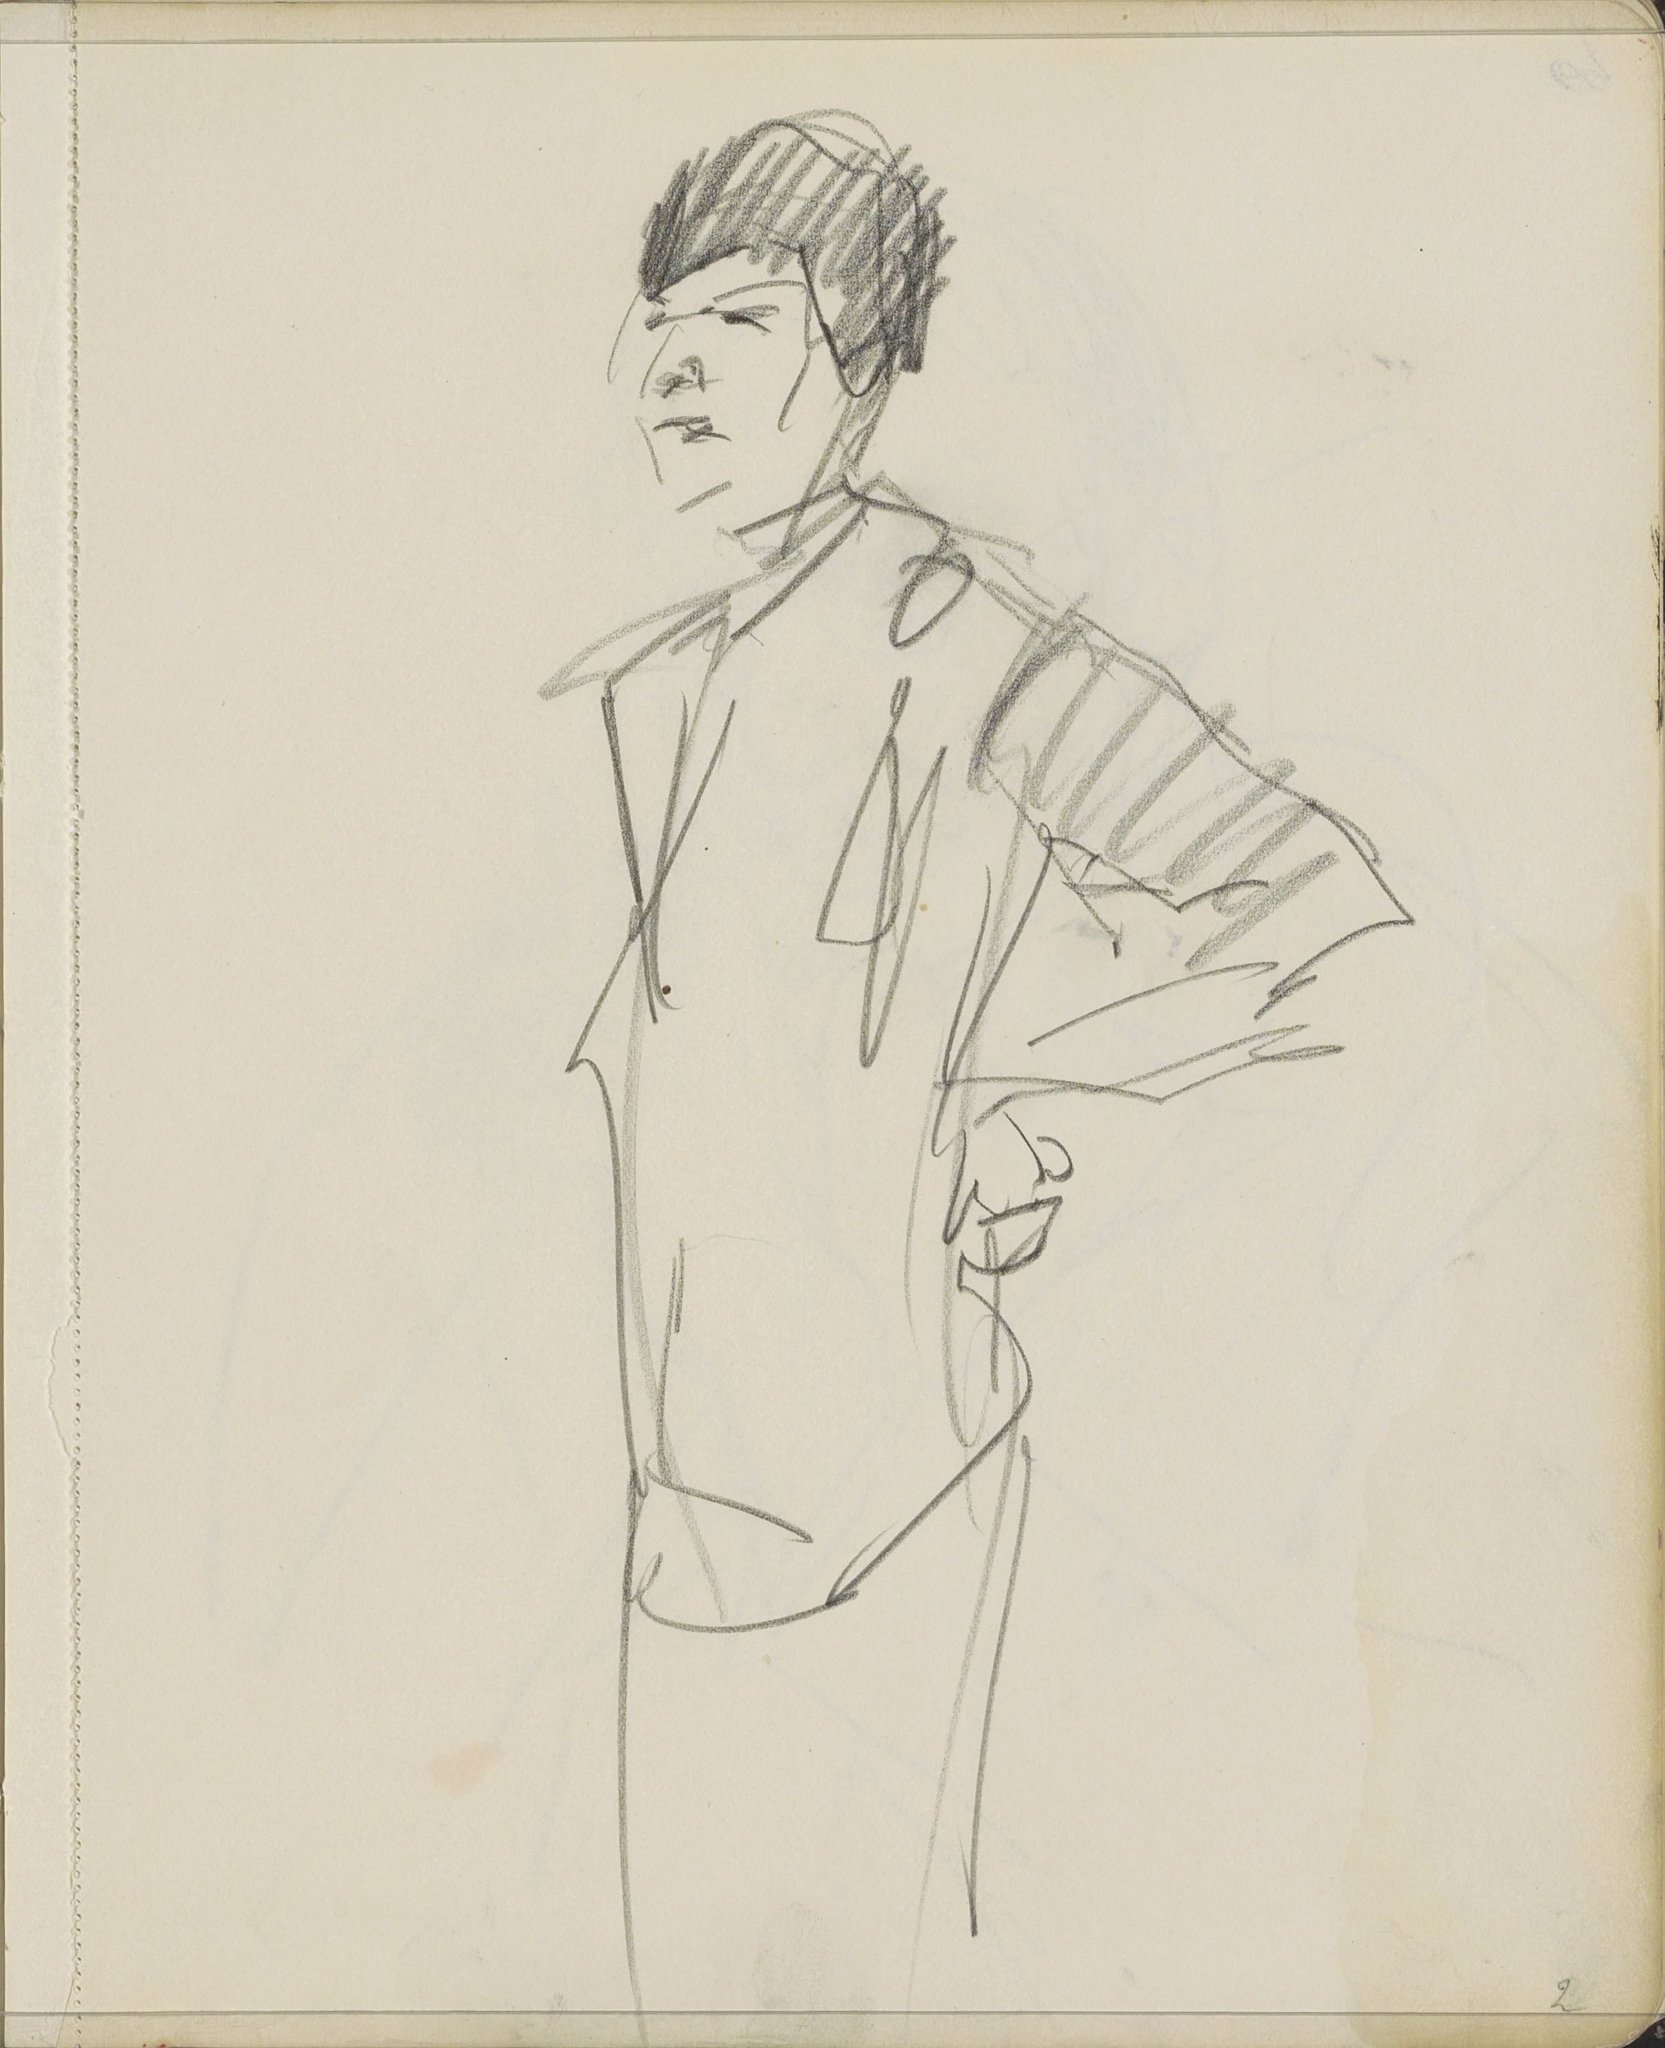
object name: sketchbook leaf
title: Staande vrouw met haar handen in haar rug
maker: isaac israels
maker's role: draughtsman, painter, print maker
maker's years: 1865-1934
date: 1925-1934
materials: paper, pencil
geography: the hague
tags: arm bent behind the back - aa - both arms or hands, adult woman (+ standing)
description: Blad 2 recto uit schetsboek XXVI met 35 bladen.